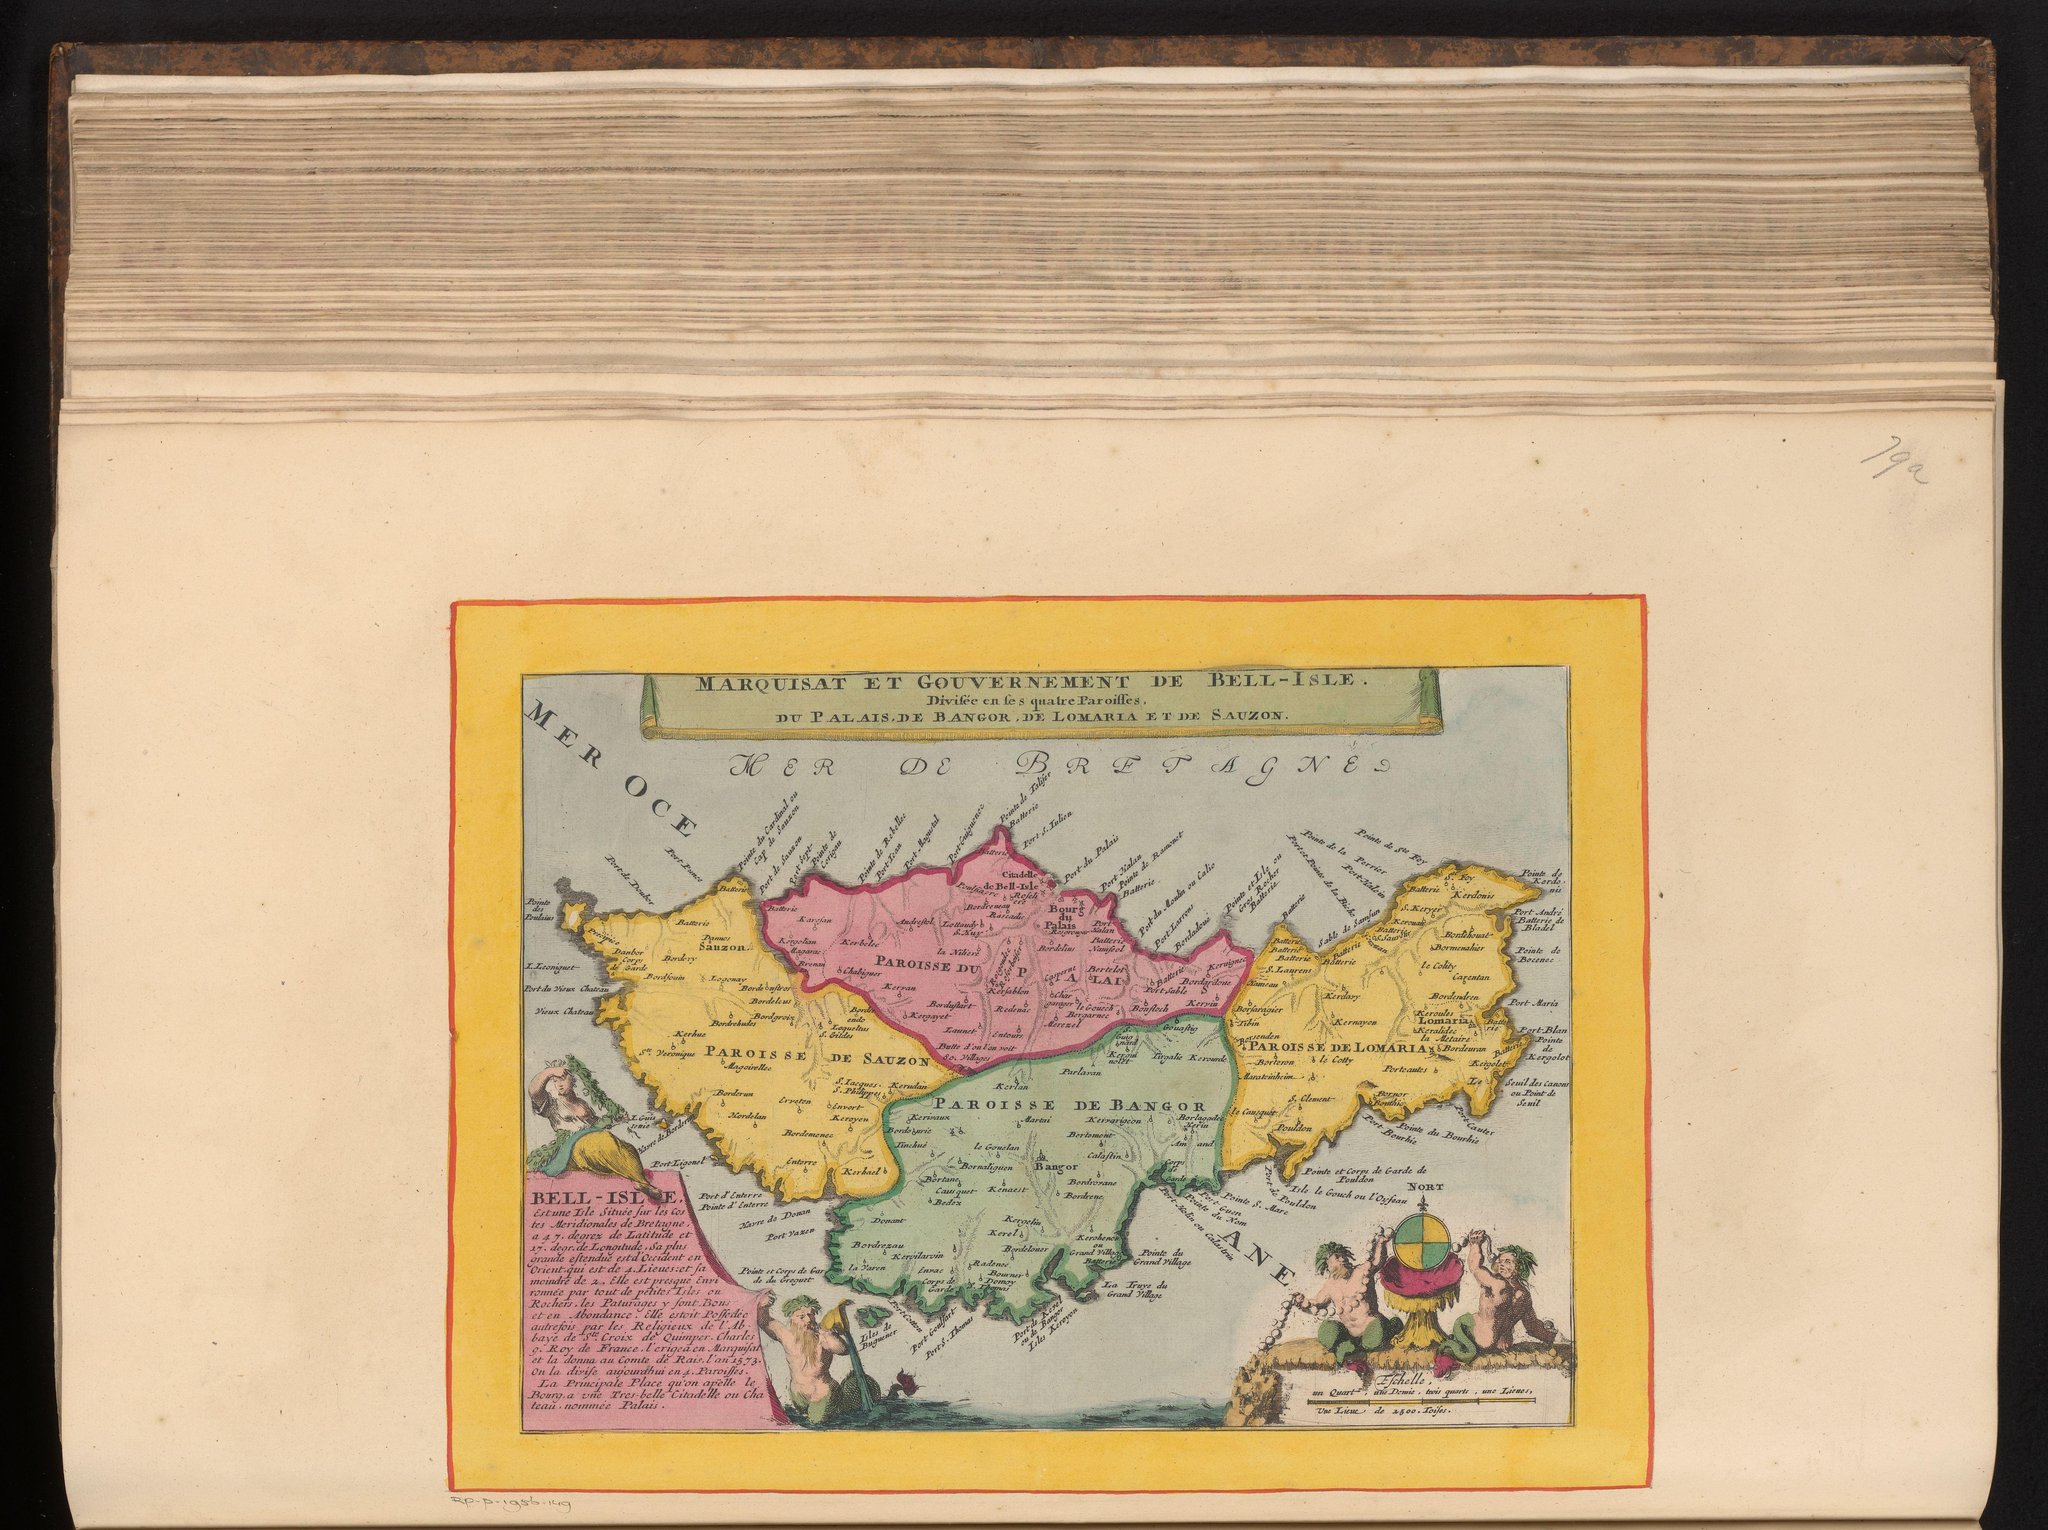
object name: print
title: Kaart van Belle-île-en-Mer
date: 1600-1699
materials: paper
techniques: engraving, etching, hand coloring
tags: maps of the continents and the polar regions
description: Deze prent maakt deel uit van een album.